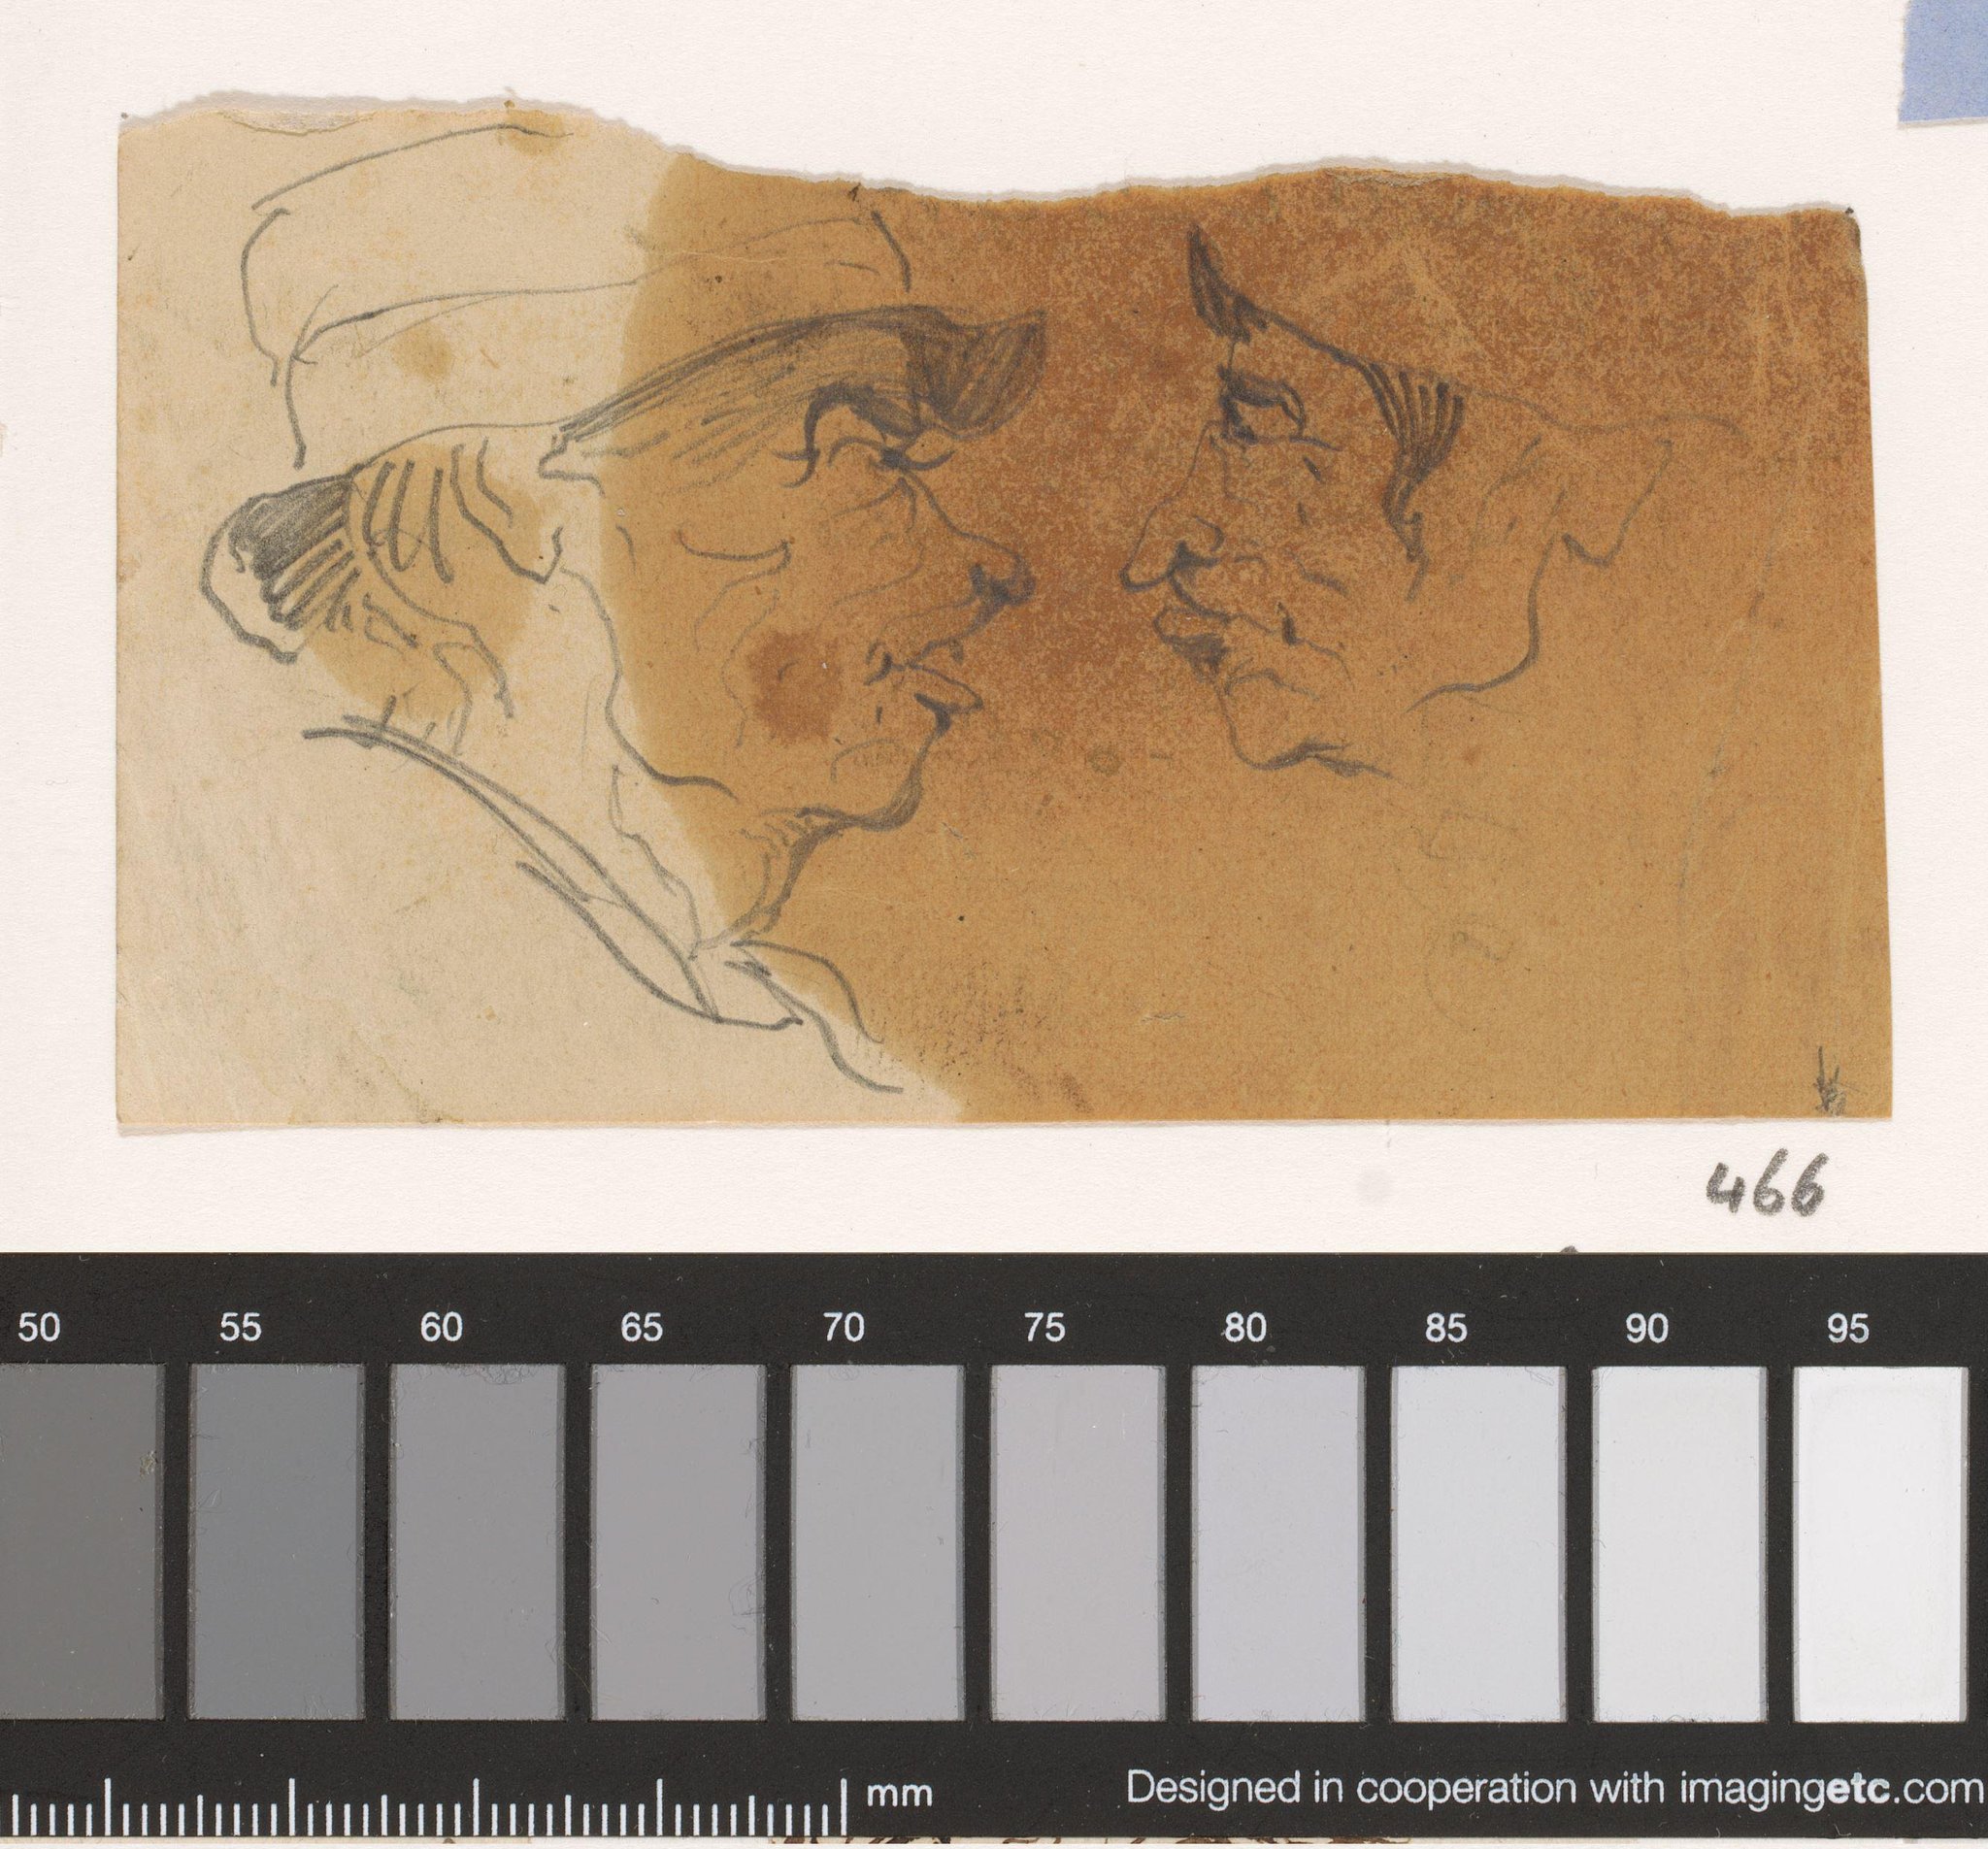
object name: drawing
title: Twee koppen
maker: johannes tavenraat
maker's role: draughtsman, painter, print maker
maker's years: 1809-1881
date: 1840-1880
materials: paper, pencil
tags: caricatures (human types)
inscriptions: collector's mark: Lugt 2228